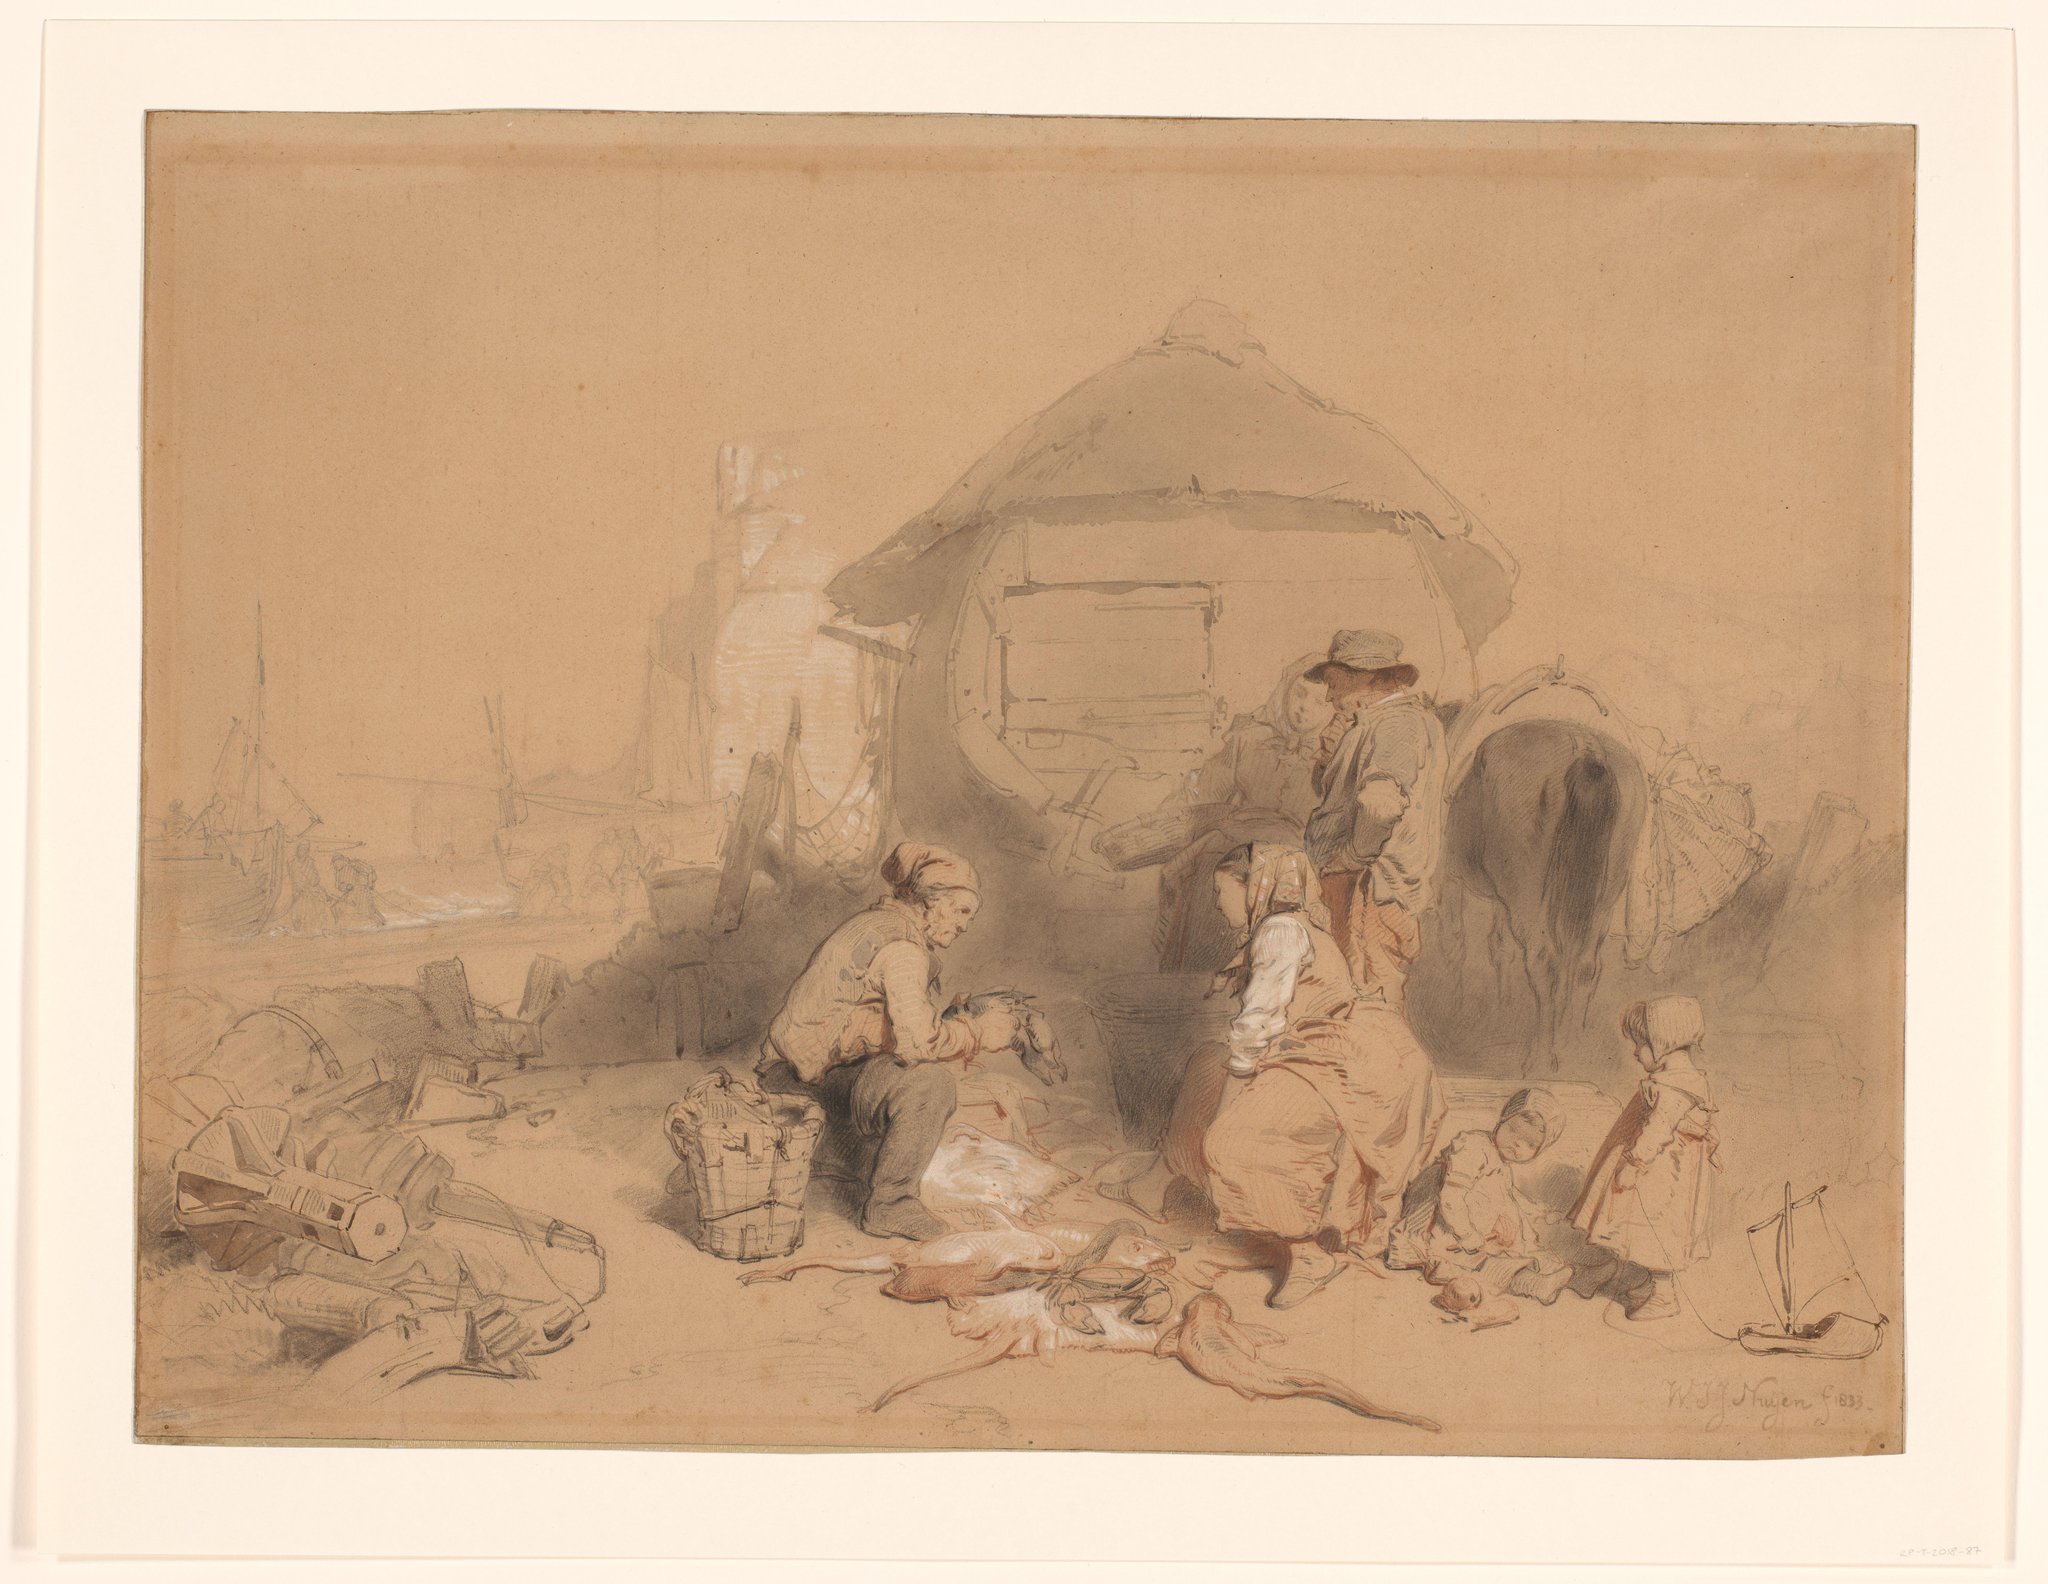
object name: drawing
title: Gesprek op het strand bij een tot behuizing omgebouwde boot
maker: wijnand nuijen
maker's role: draughtsman, painter, print maker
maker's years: 1813-1839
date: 1833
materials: chalk, paper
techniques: brush in colors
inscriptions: inscription: ‘W.J.J. Nuijen 1833’